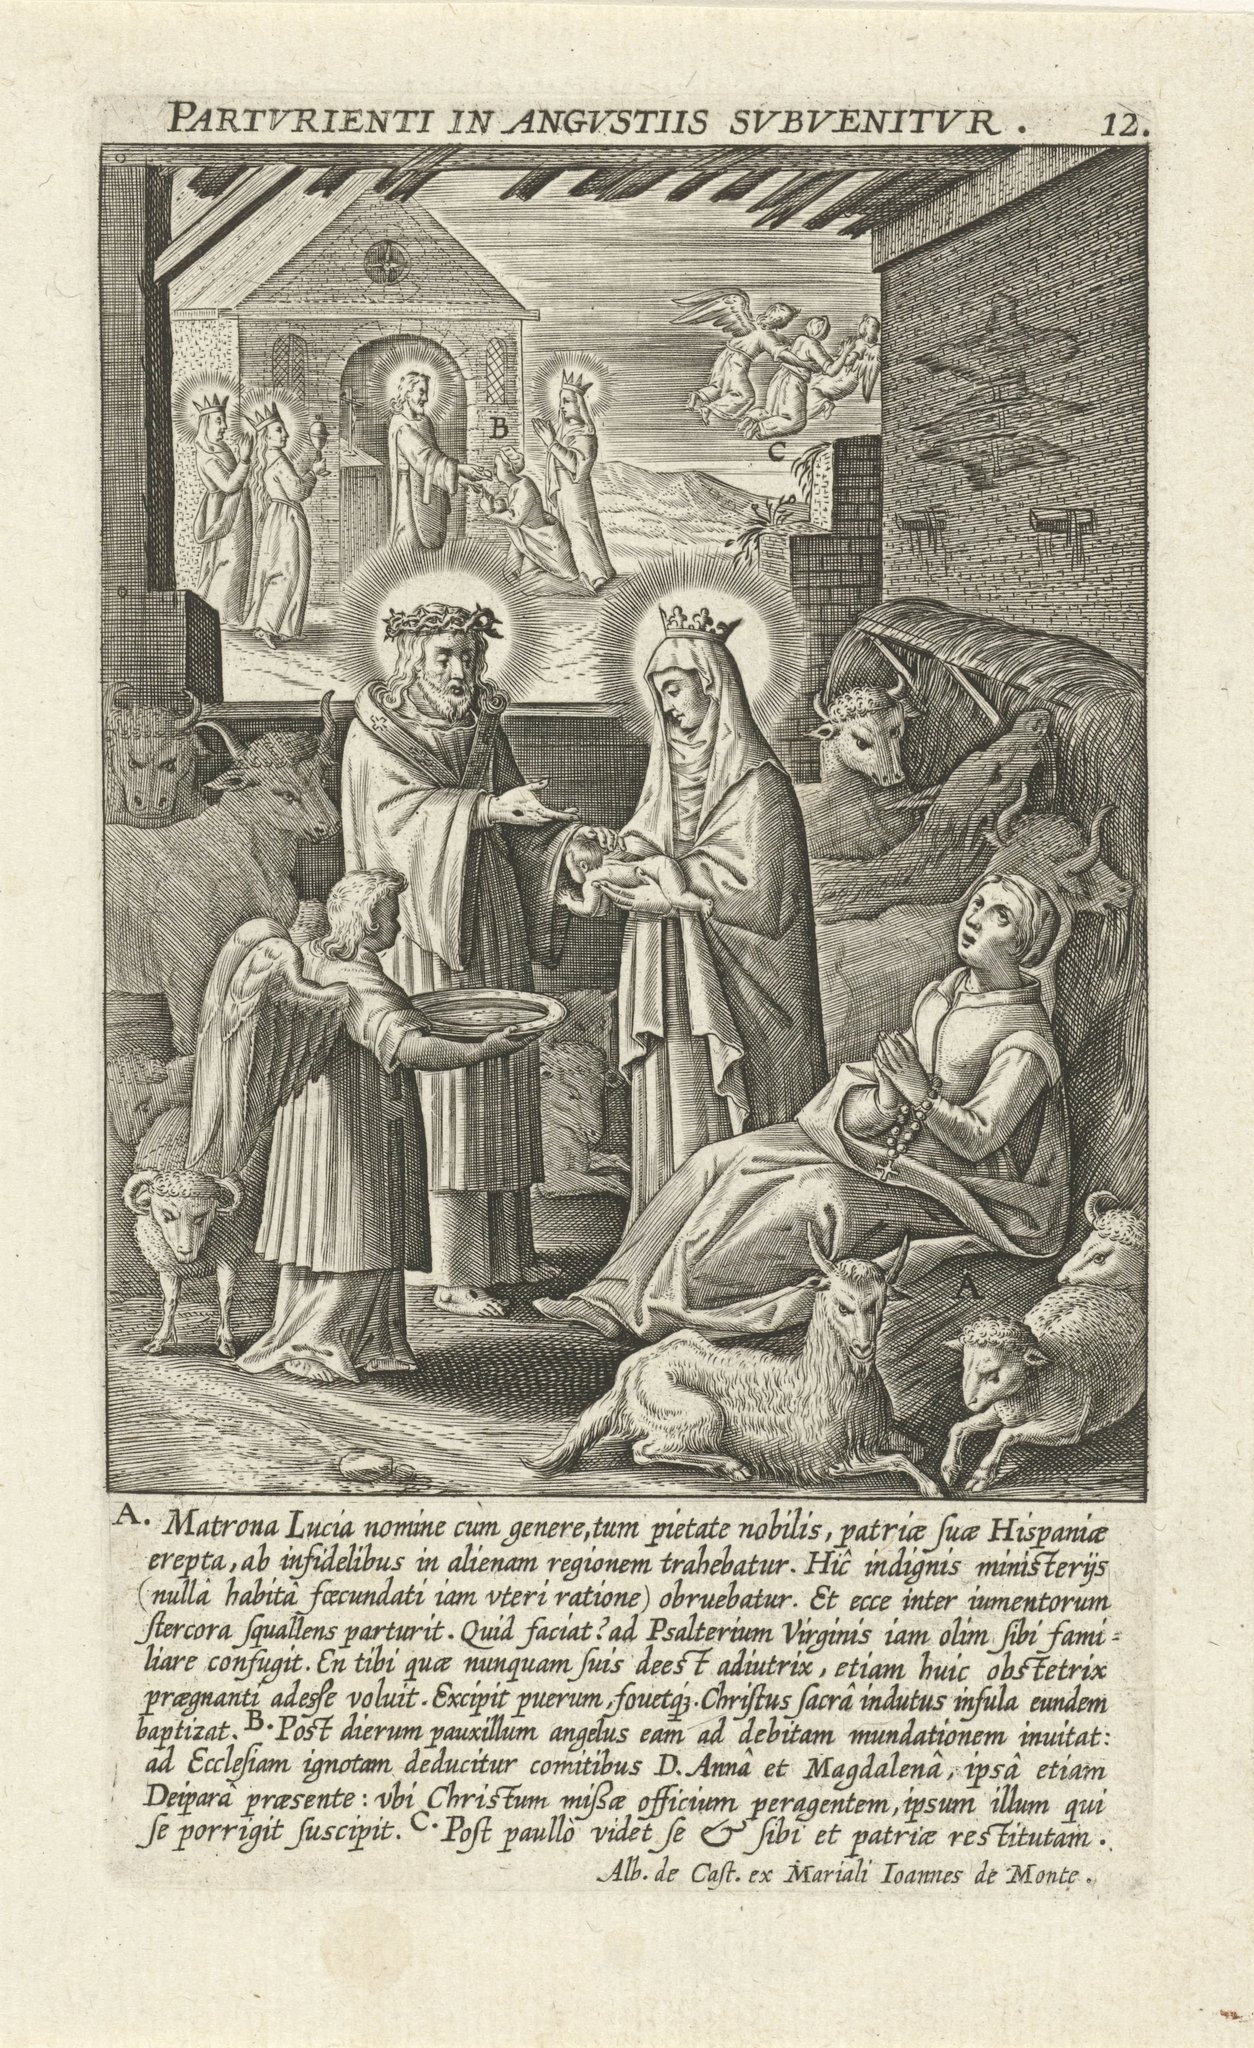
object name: print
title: Miracula et Beneficia SS. Rosario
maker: theodoor galle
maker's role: print maker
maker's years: 1571-1633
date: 1610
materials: paper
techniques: engraving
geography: antwerp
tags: barn, aids for prayer, e.g. rosary (+ variant), the eucharist ~ the fourth of the seven sacraments (+ christ (bearded)), baptism, christening ceremony ~ the first of the seven sacraments (+ christ (bearded)), the virgin mary, angels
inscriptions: collector's mark: Lugt 2228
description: Een vrouw (Lucia) heeft een kind gebaard in een stal. Voor zij sterft, bidt ze met de rozenkrans tot de maagd Maria dat haar kind gedoopt zal worden. Christus en Maria verschijnen en dopen het kind. Op de achtergrond krijgt de vrouw haar laatste sacramenten, uitgevoerd door Christus en Maria. Daarna wordt ze door engelen naar de hemel gevoerd. De prent heeft een Latijns onderschrift met legende en maakt deel uit van een vijftiendelige serie over de mirakels van de rozenkrans.